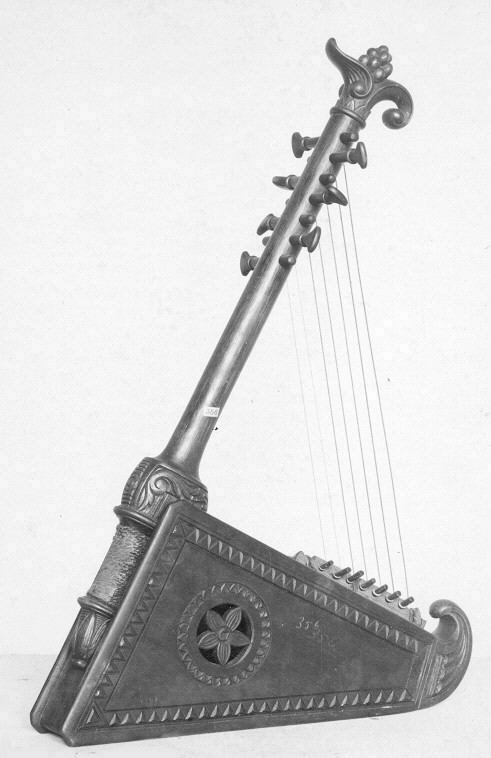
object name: junuk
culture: turkish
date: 1867-1900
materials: wood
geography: turkey